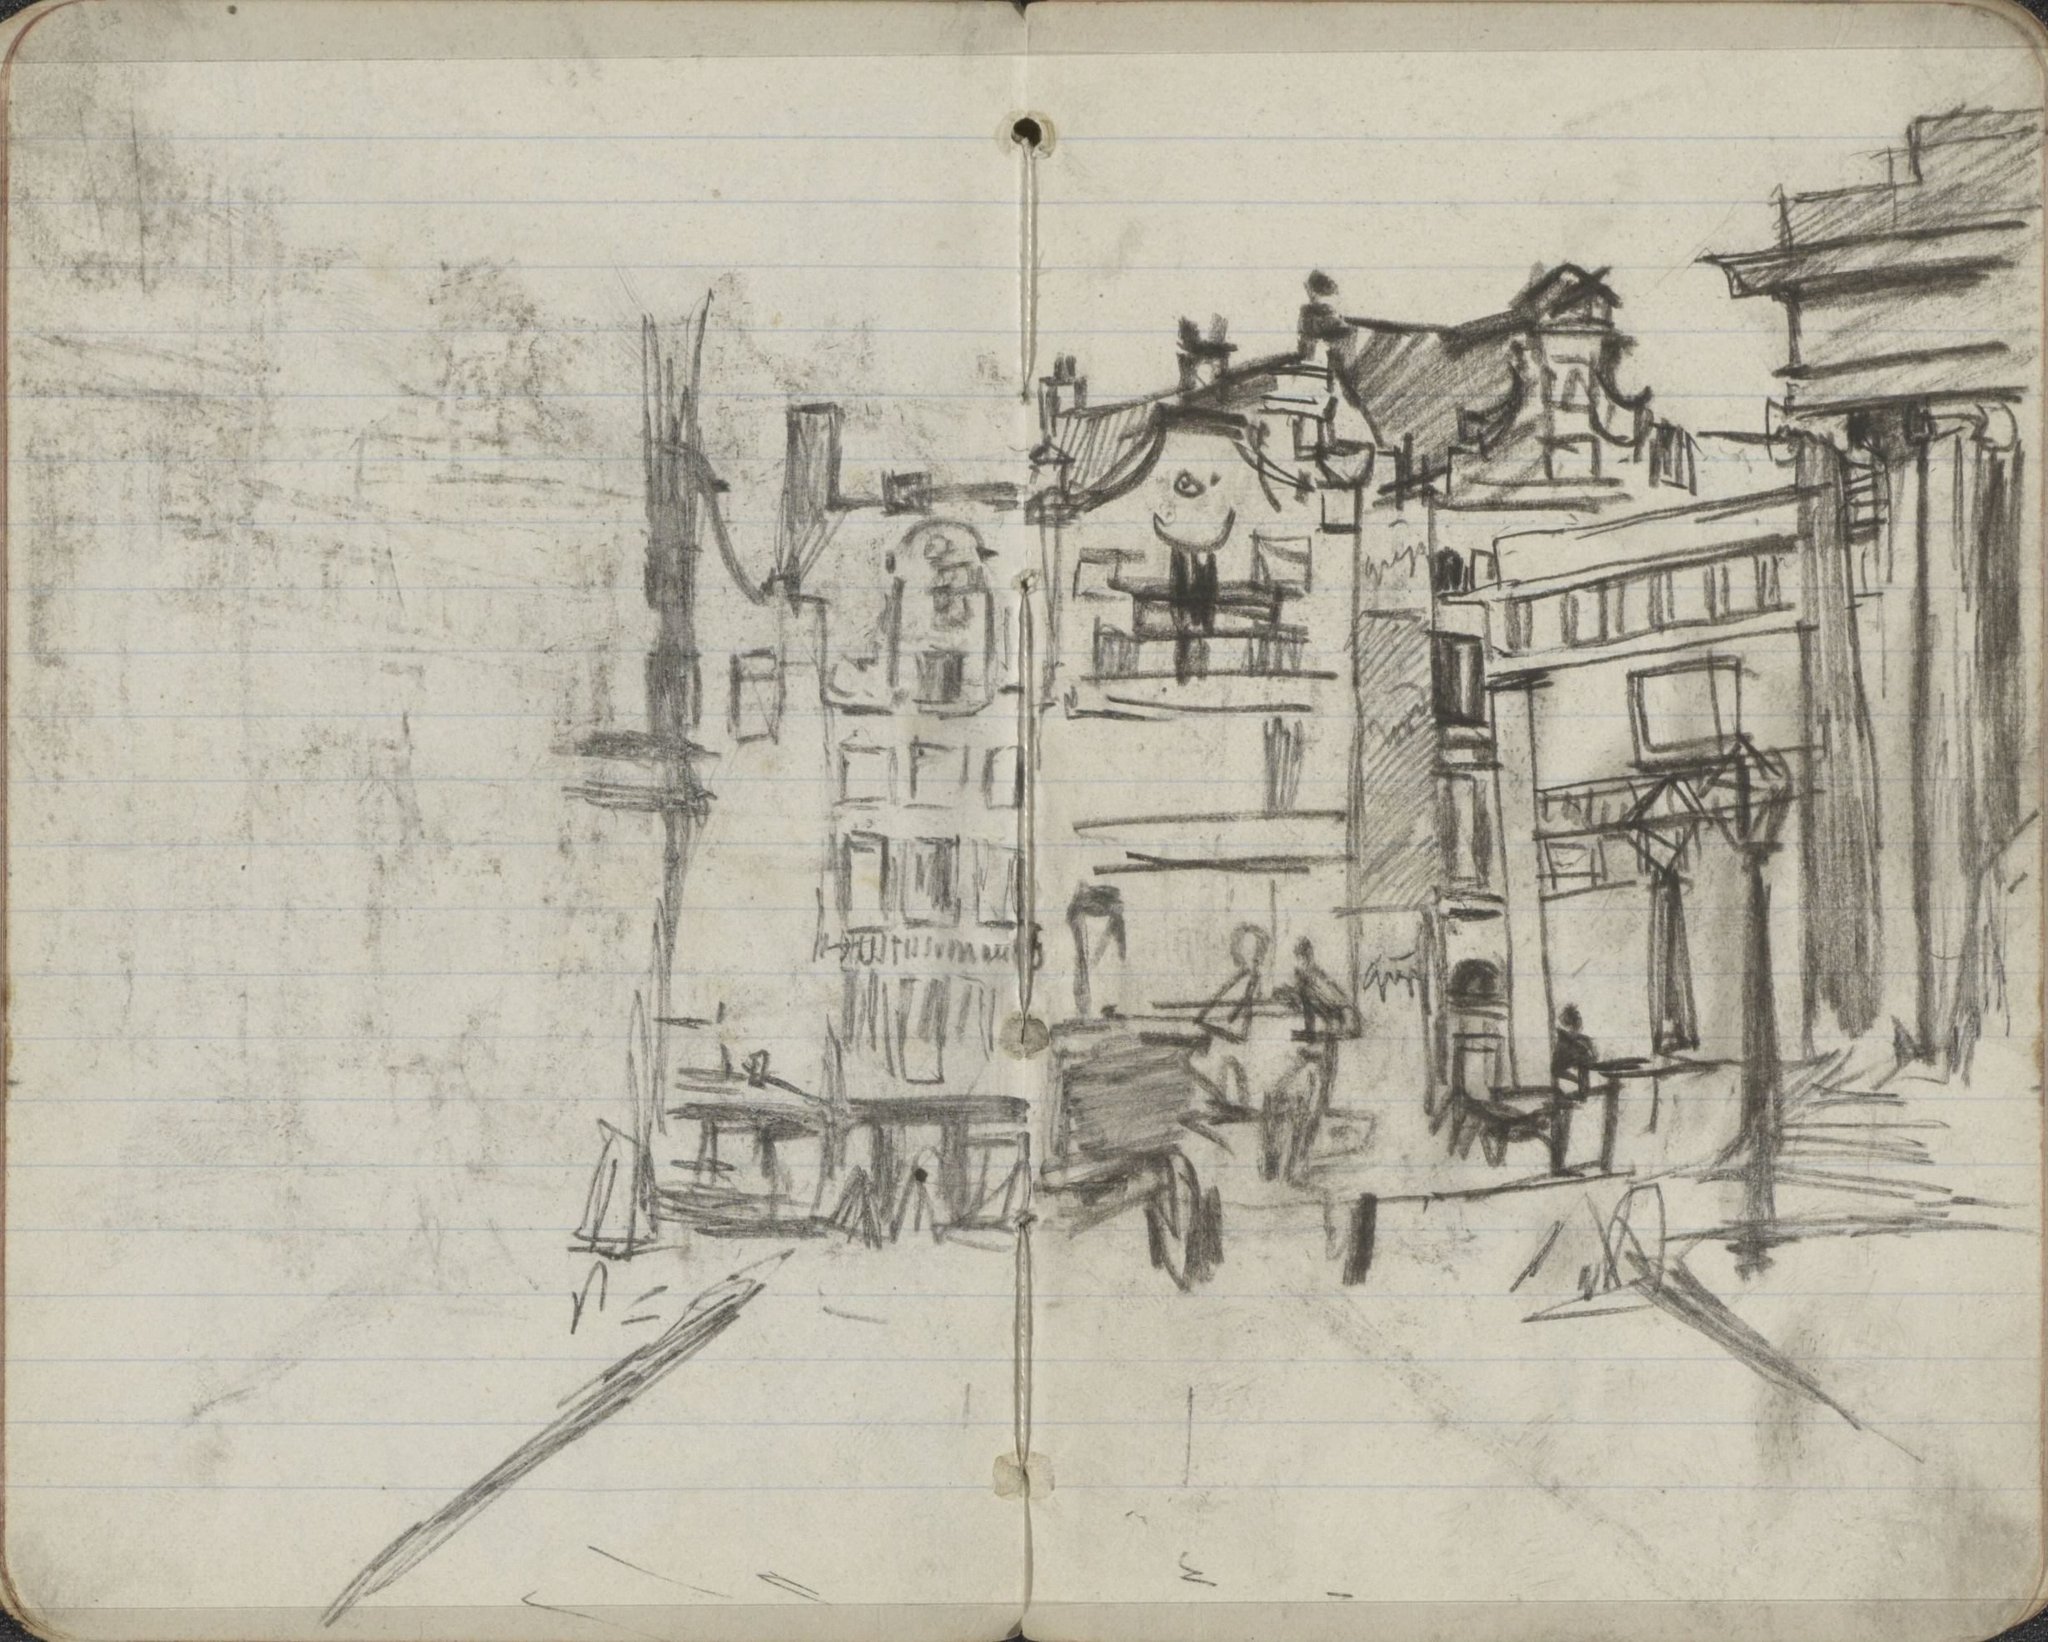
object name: sketchbook leaf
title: Gezicht op de Dam te Amsterdam met de Beurs van Zocher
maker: george hendrik breitner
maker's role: draughtsman, painter, print maker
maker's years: 1857-1923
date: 1894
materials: chalk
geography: amsterdam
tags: square, place, circus, etc., civic architecture; edifices; dwellings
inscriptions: kleurnotitie, handgeschreven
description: Ter hoogte van de Vijgendam. Pagina 33 en pagina 34 uit een schetsboek met 31 bladen.